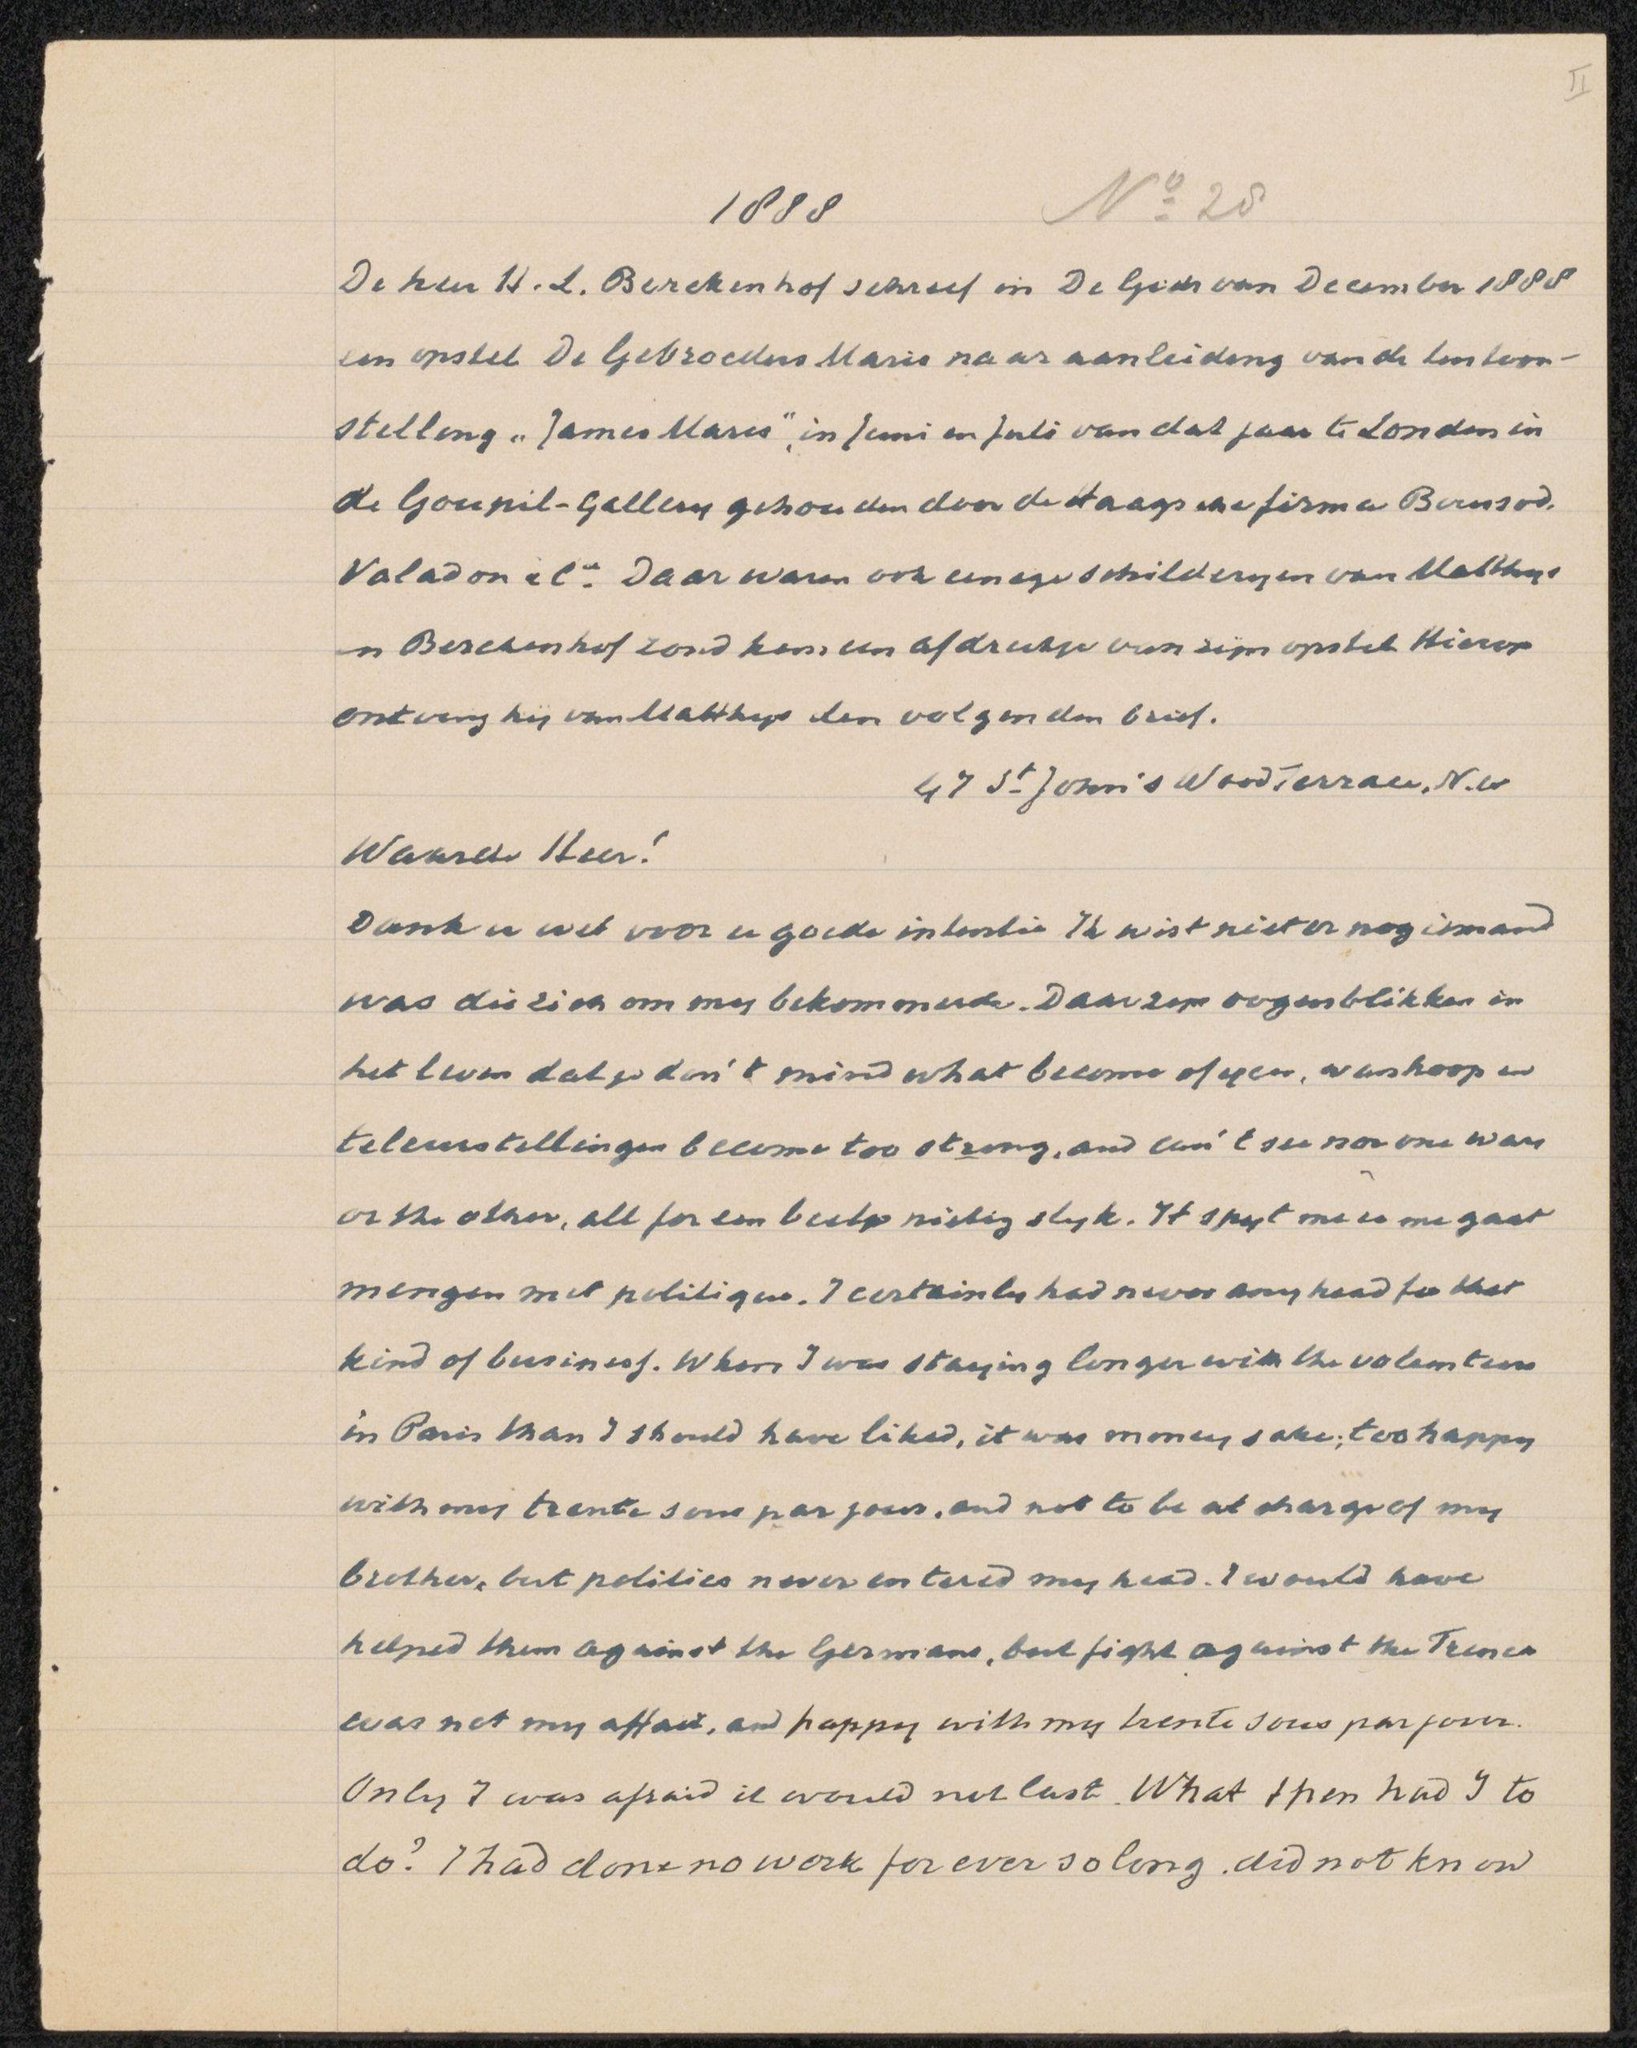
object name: letter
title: Geannoteerde transcriptie van een brief aan H.L. Berckenhoff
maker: pieter haverkorn van rijsewijk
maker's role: museumdirecteur, publicist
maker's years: 1839-1919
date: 1812-1888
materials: ink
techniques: pen, writing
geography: london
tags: glasgow, daniel cottier, painter, print maker, draughtsman, jacob maris, h.l. berckenhoff, painting (including book-illumination, miniature-painting), money, paris, england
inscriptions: collector's mark: Lugt 2233